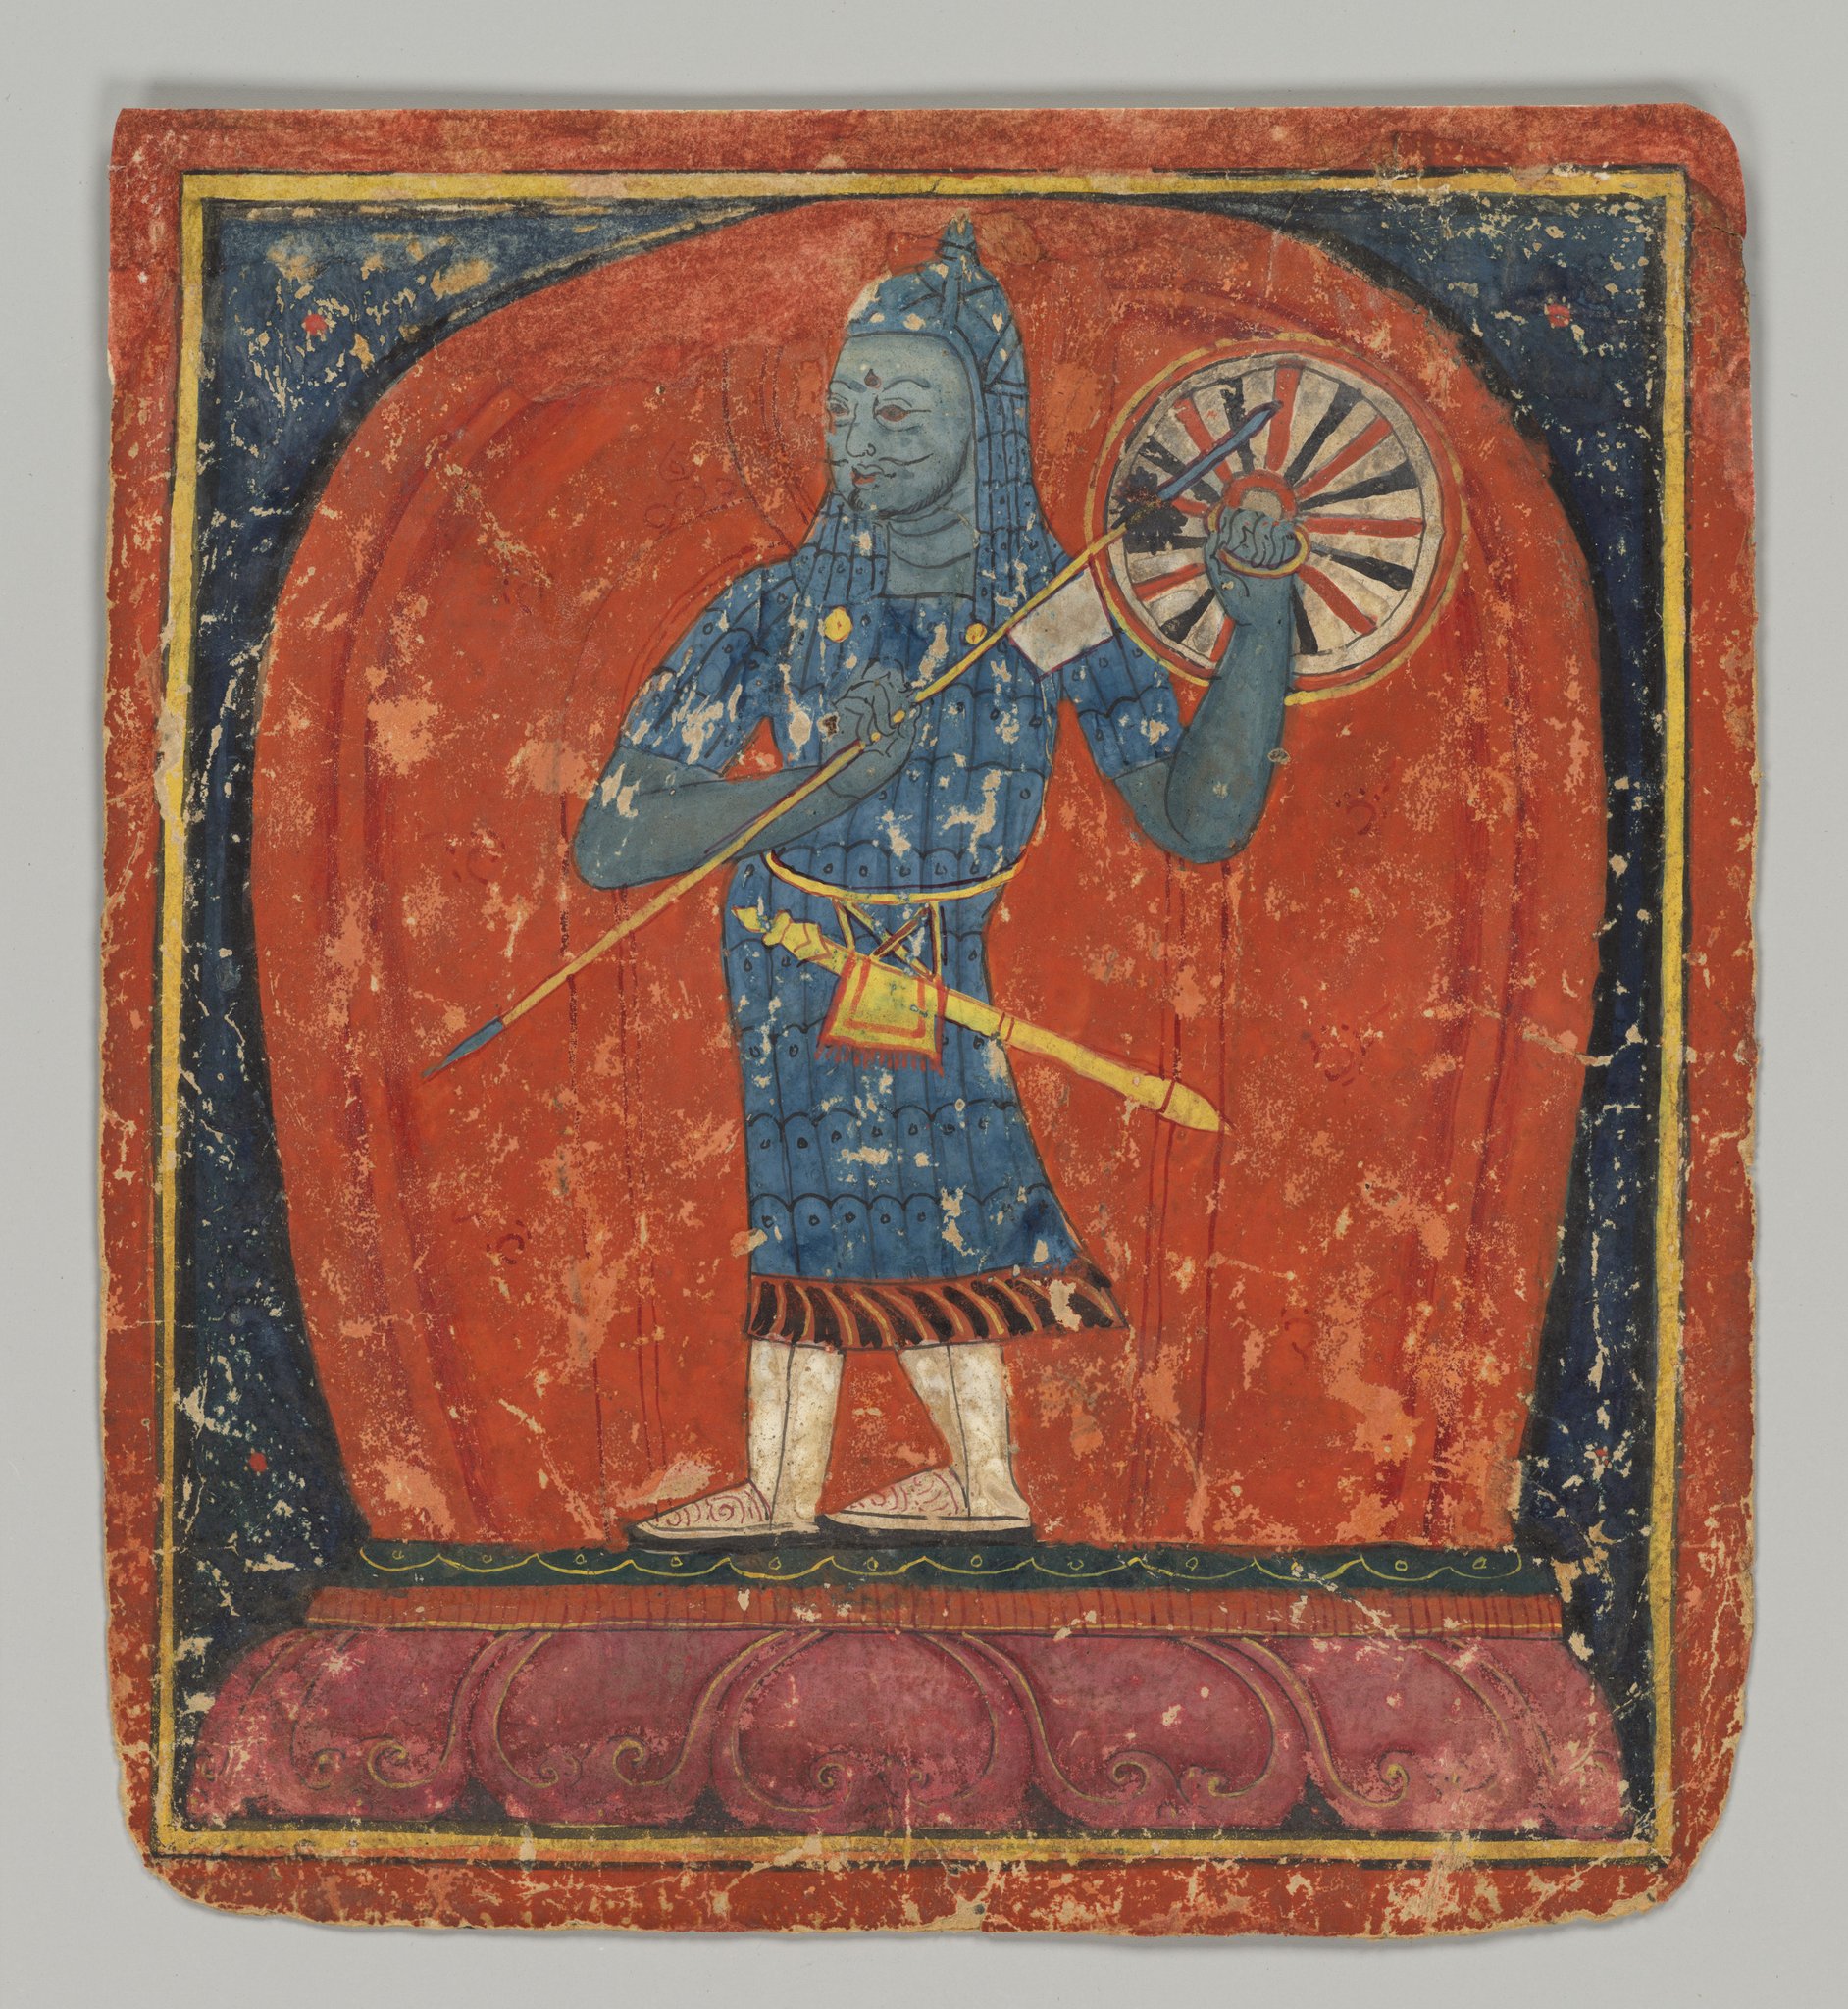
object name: initiation card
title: Initiation Card (Tsakalis)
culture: tibetan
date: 1401-1433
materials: paper, watercolor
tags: men,buddhism